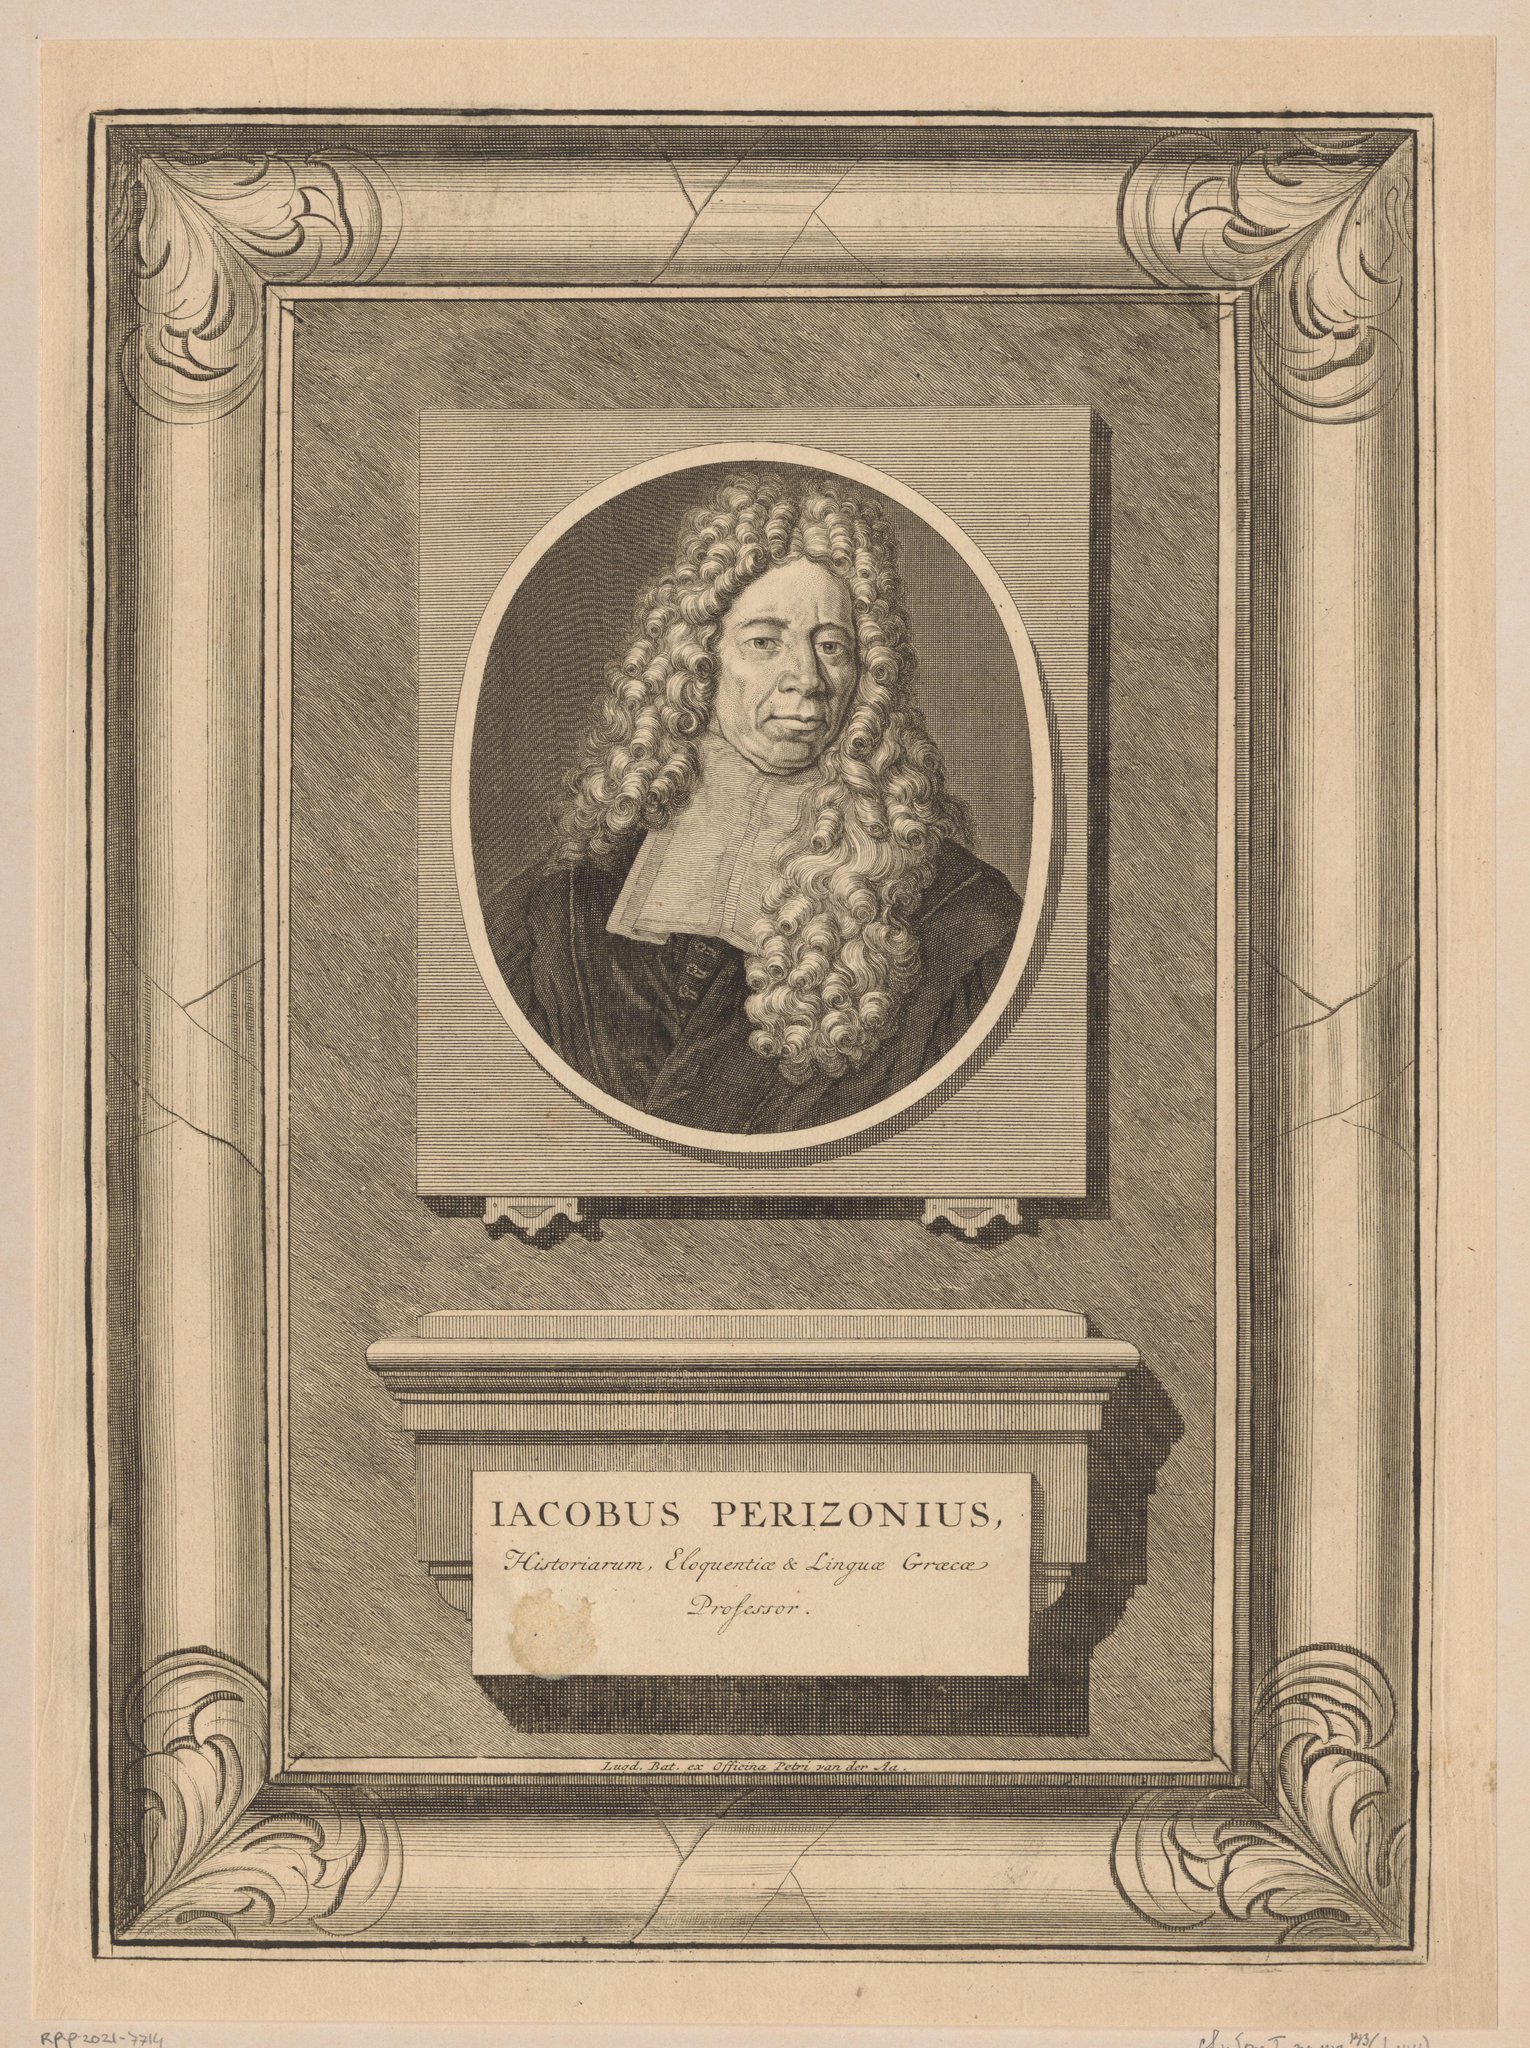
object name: print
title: Portret van Jacobus Perizonius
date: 1716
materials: paper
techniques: engraving, etching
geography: leiden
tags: leiden, adult man, historical persons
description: Prent waarschijnlijk uit: Effigies Professorum aliorumque illustrium Virorum Academiae Lugduno-Batavae. Leiden: Pieter van der Aa, [1716].